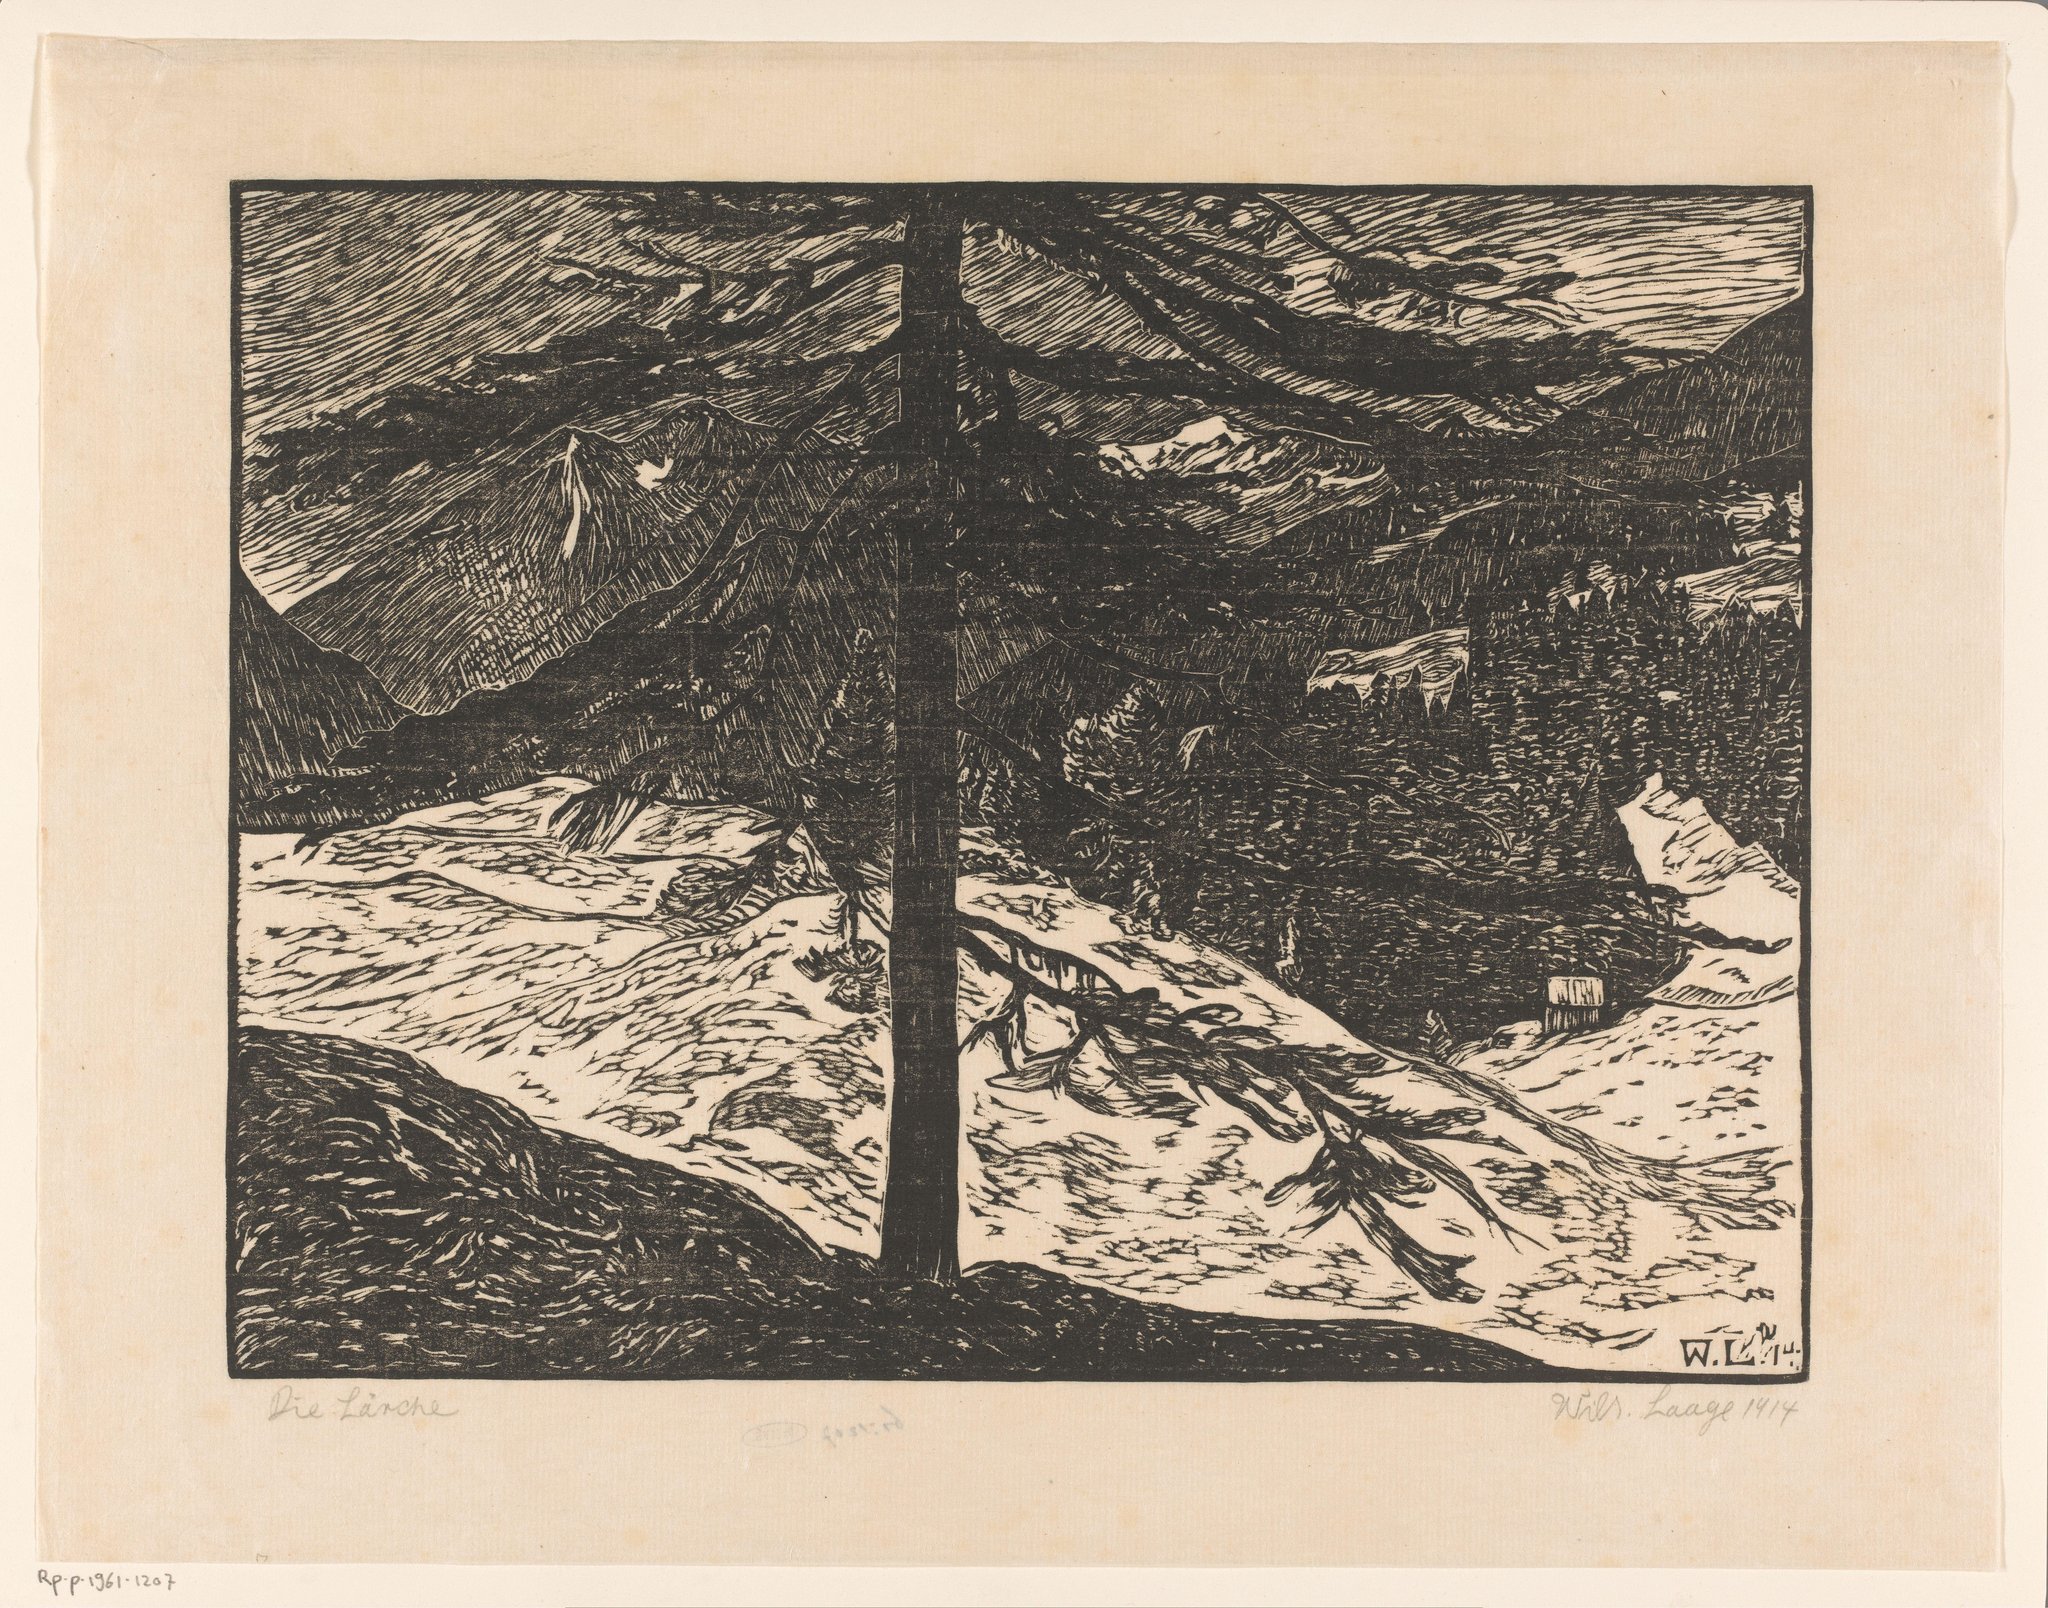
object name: print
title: Die Lärche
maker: wilhelm laage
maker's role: print maker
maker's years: 1868-1930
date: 1914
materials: paper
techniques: woodcut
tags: trees, snow, mountains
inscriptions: collector's mark: Lugt 2228